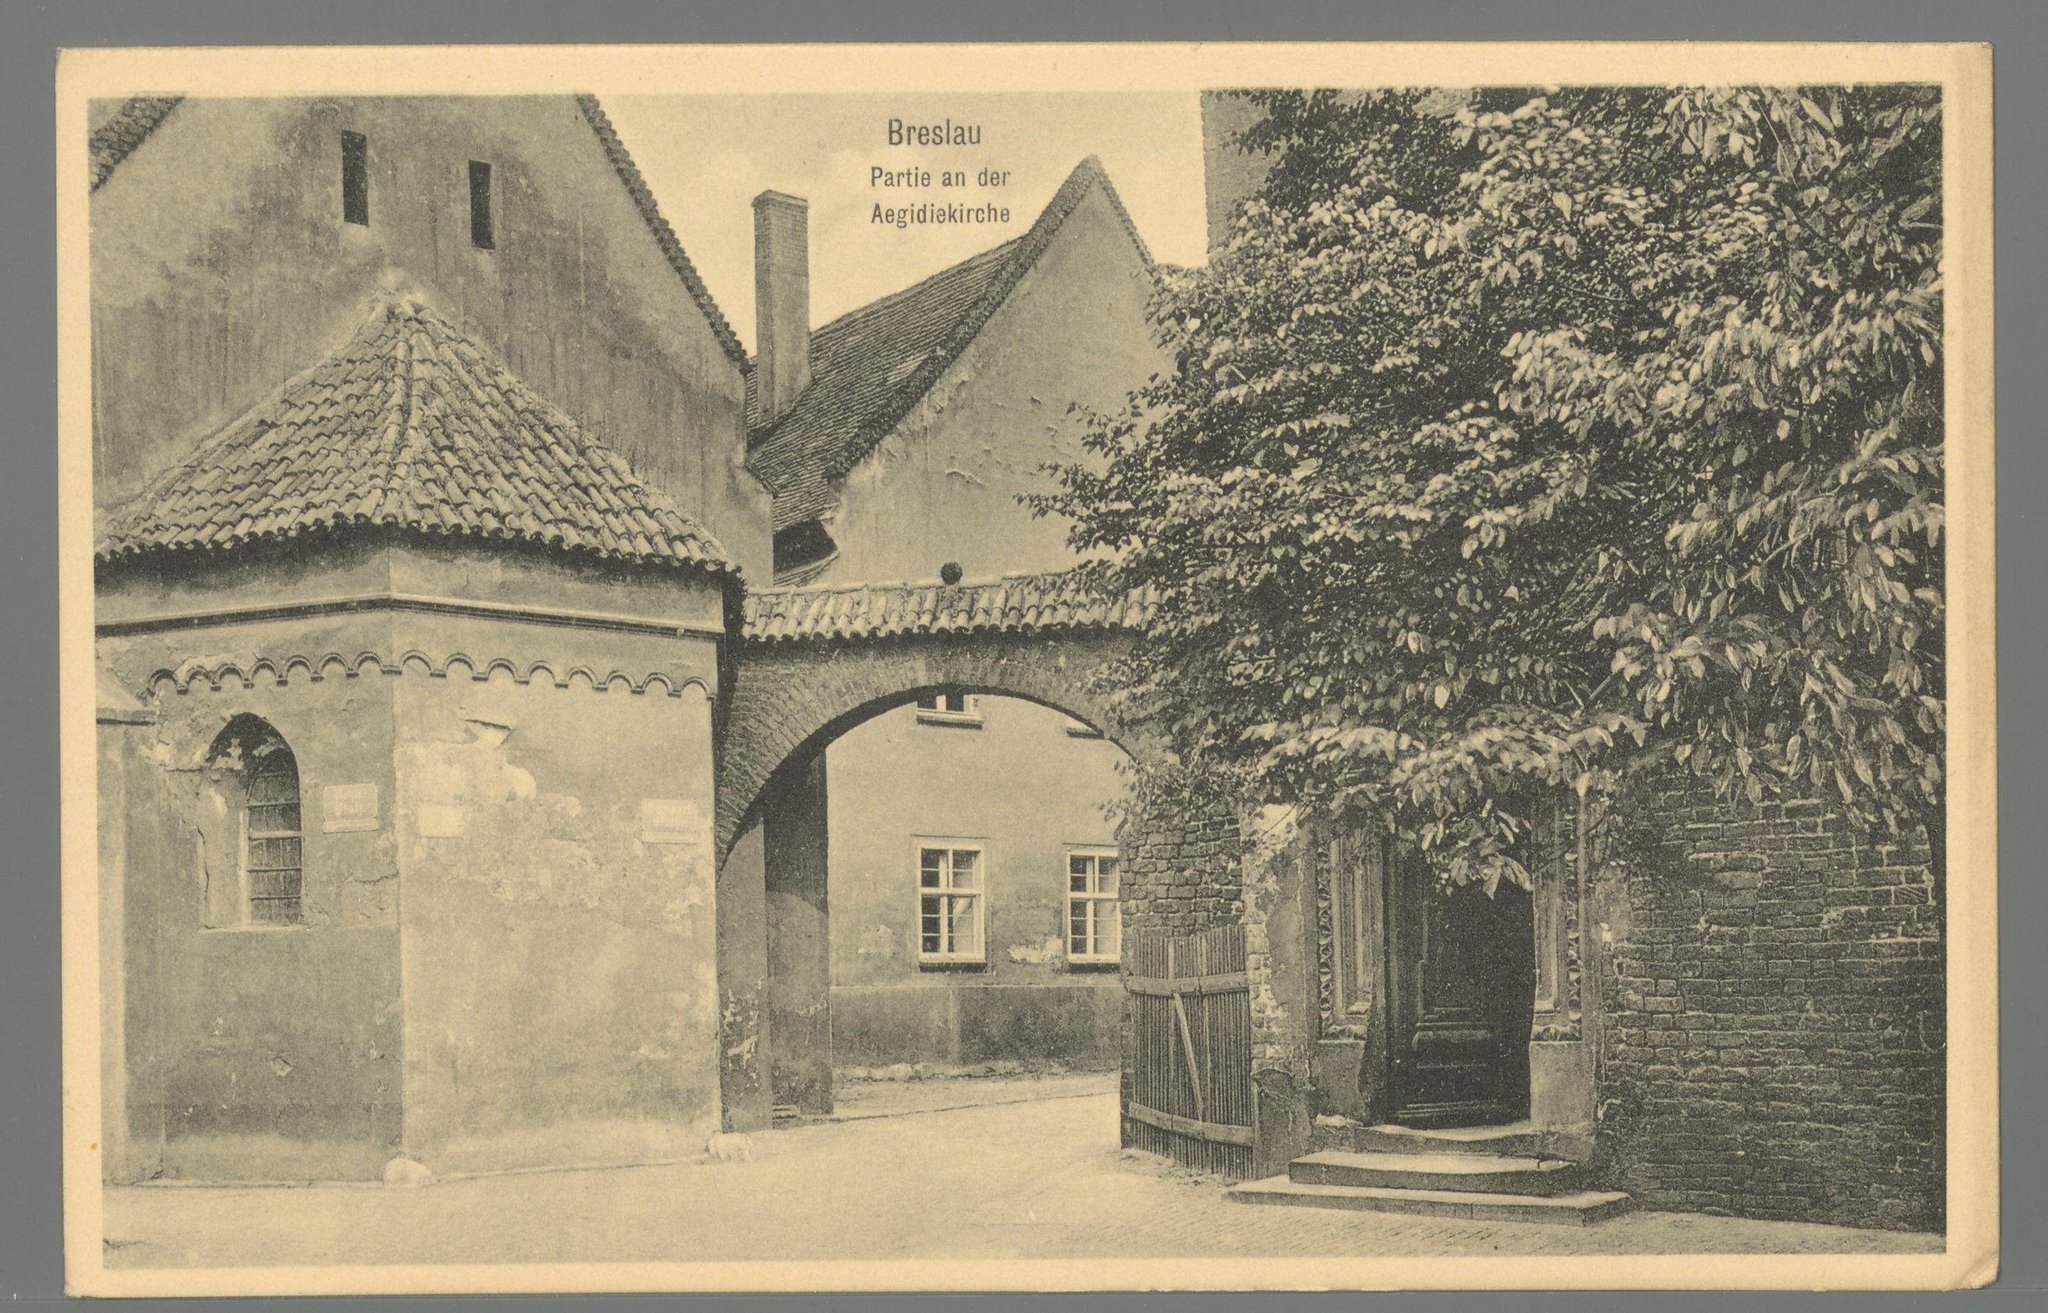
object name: ansichtkaart, prentbriefkaart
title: Breslau. Partie an der Aegidiekirche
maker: Anonymous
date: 1908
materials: cardboard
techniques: photograph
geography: breslau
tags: church (exterior)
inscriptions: date